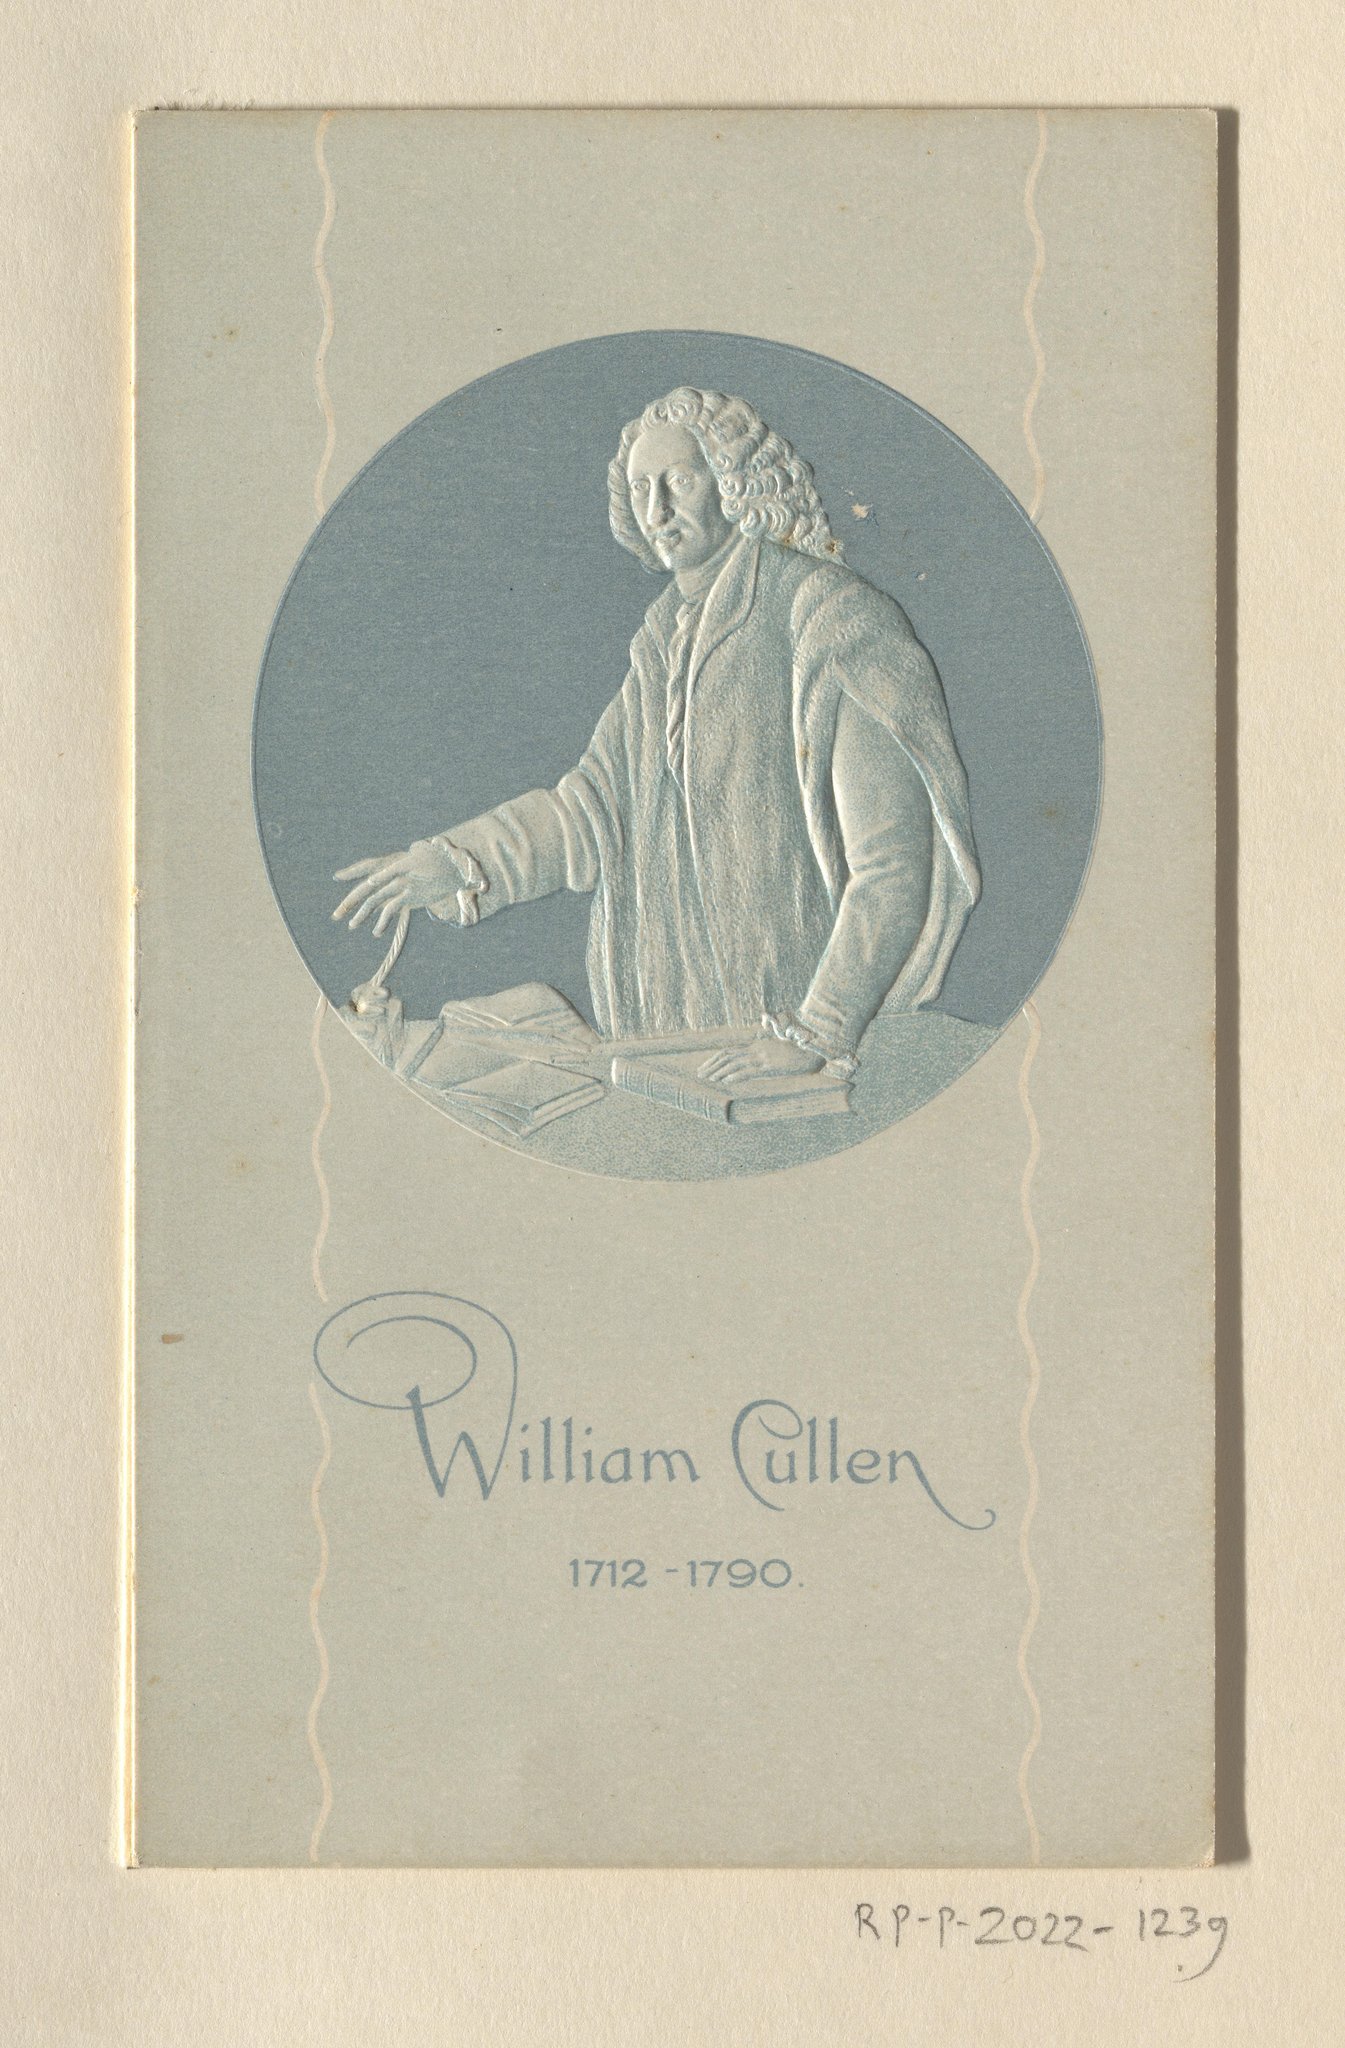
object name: advertising card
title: Galerie berühmter Ärzte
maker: Anonymous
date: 1910-1915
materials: paper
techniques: blind stamped, lithograph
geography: germany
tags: advertising, physician, doctor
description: Kaart met portretbuste van de arts William Cullen. Onderdeel van de serie kaarten in reliëfdruk uitgebracht als reclame voor de medische producten van Tropon-Werke, Mülheim am Rhein.